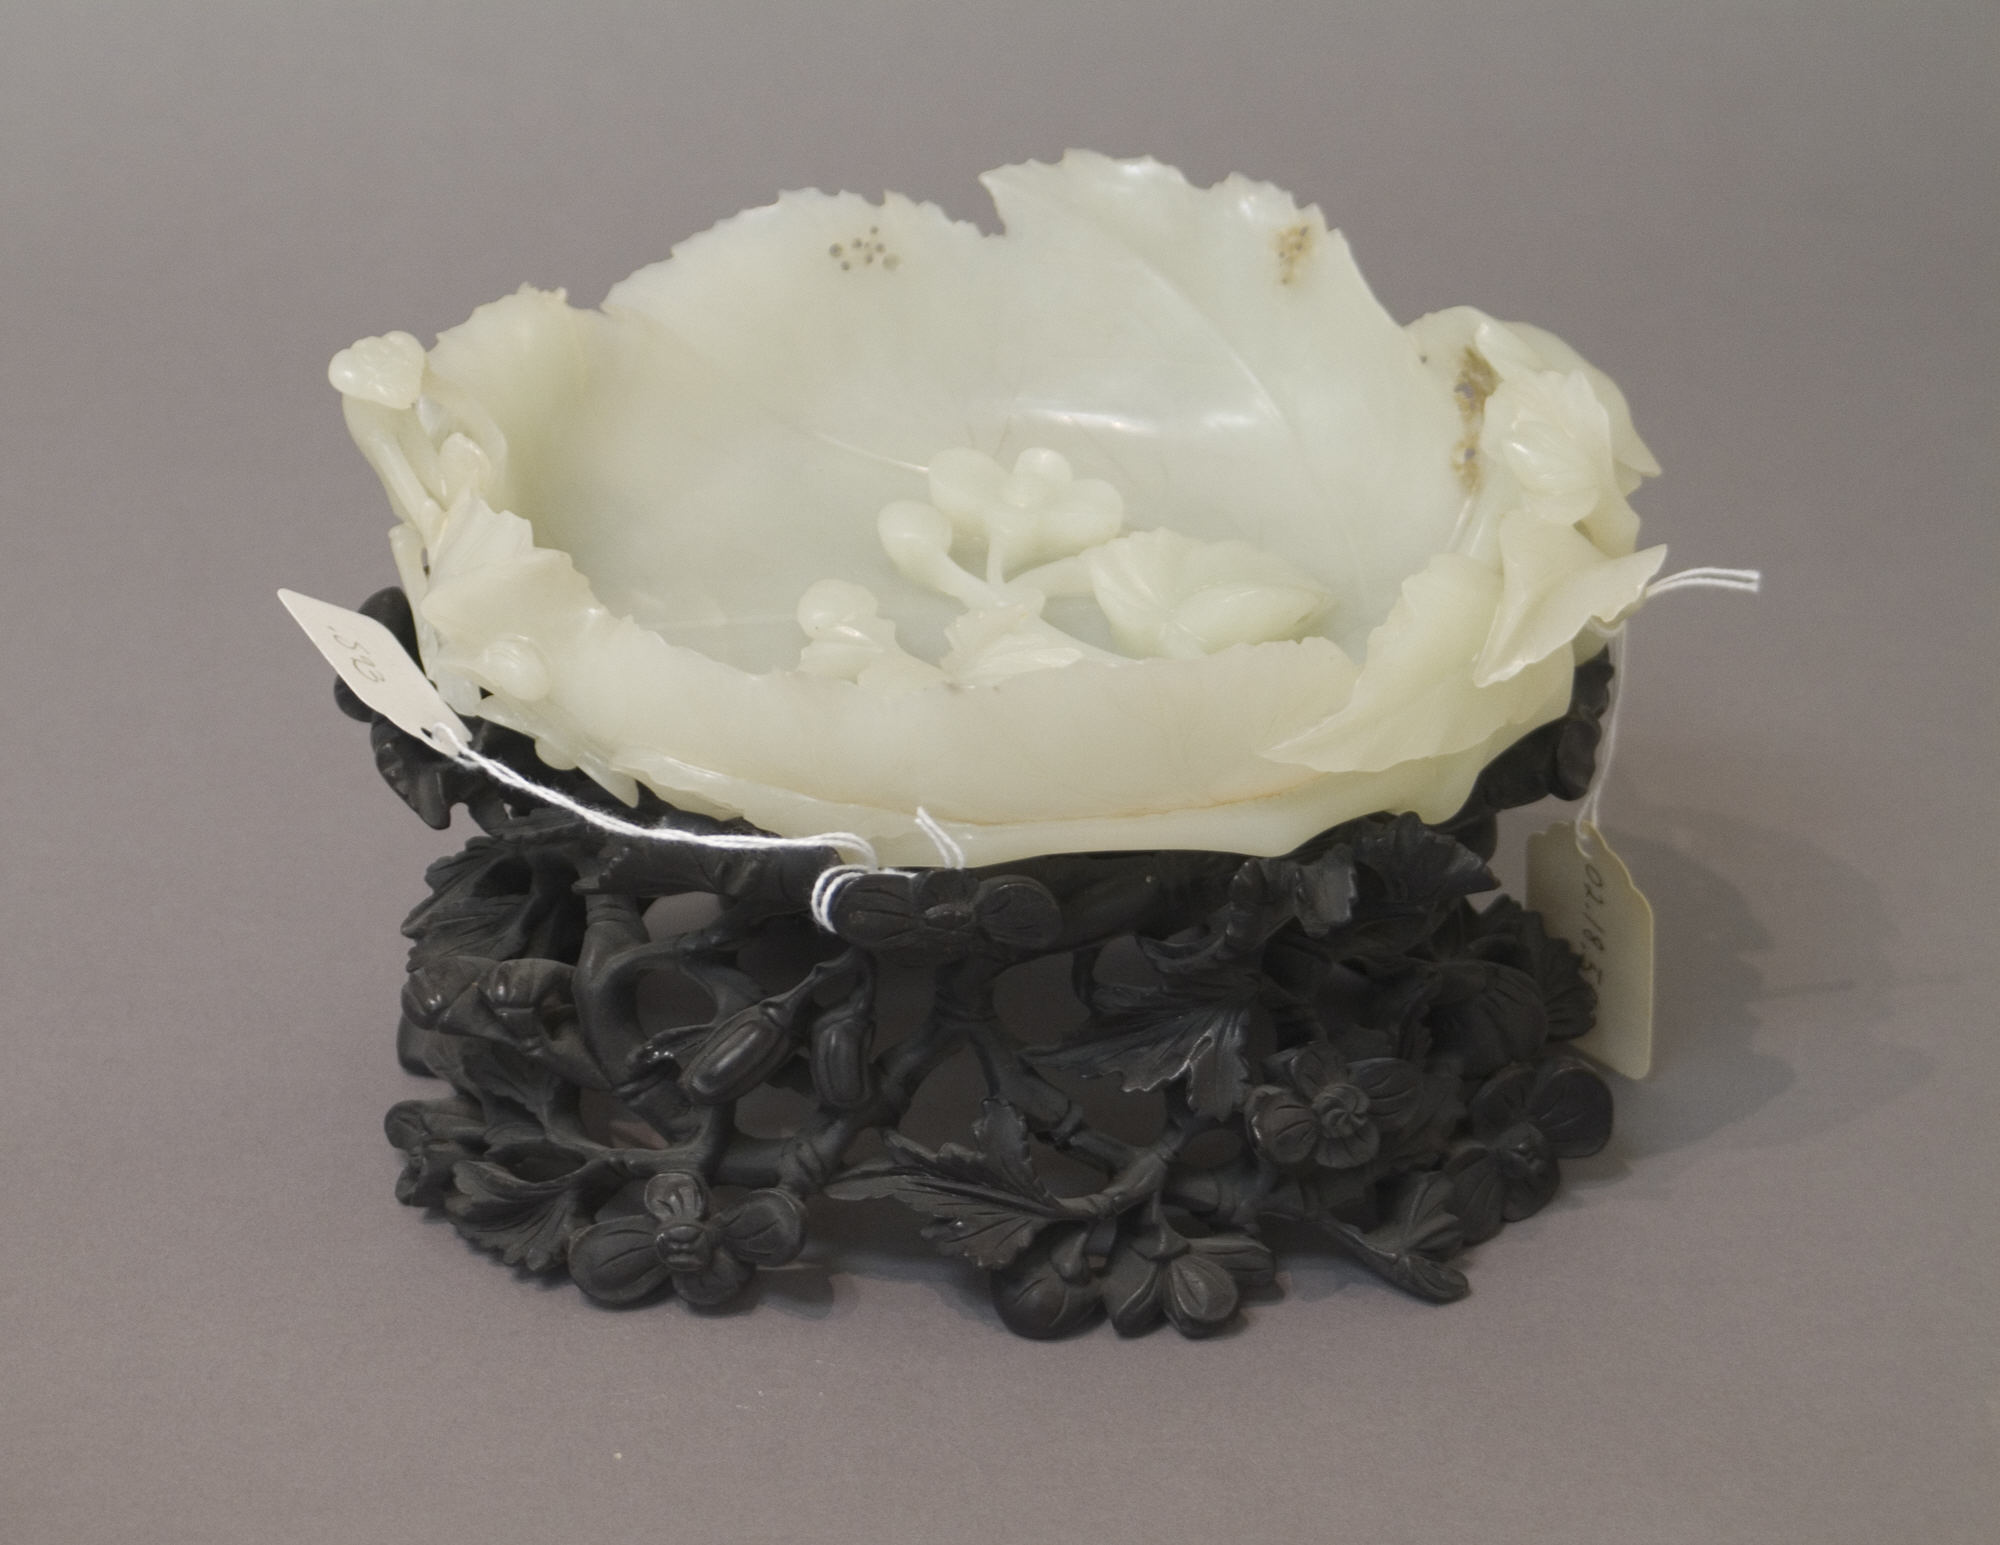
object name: artist's dish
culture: chinese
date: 1736-1795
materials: jade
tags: flowers